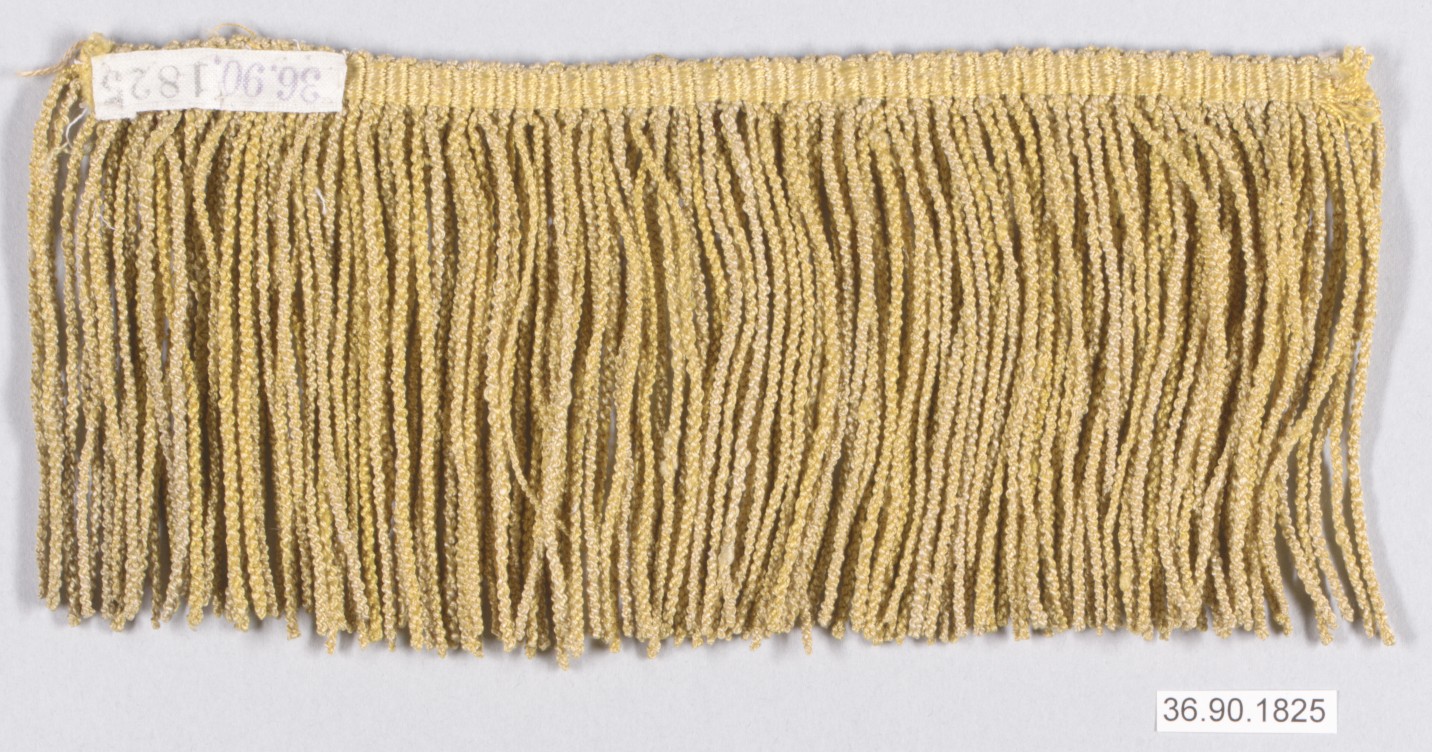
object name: fringe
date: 1867-1900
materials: silk